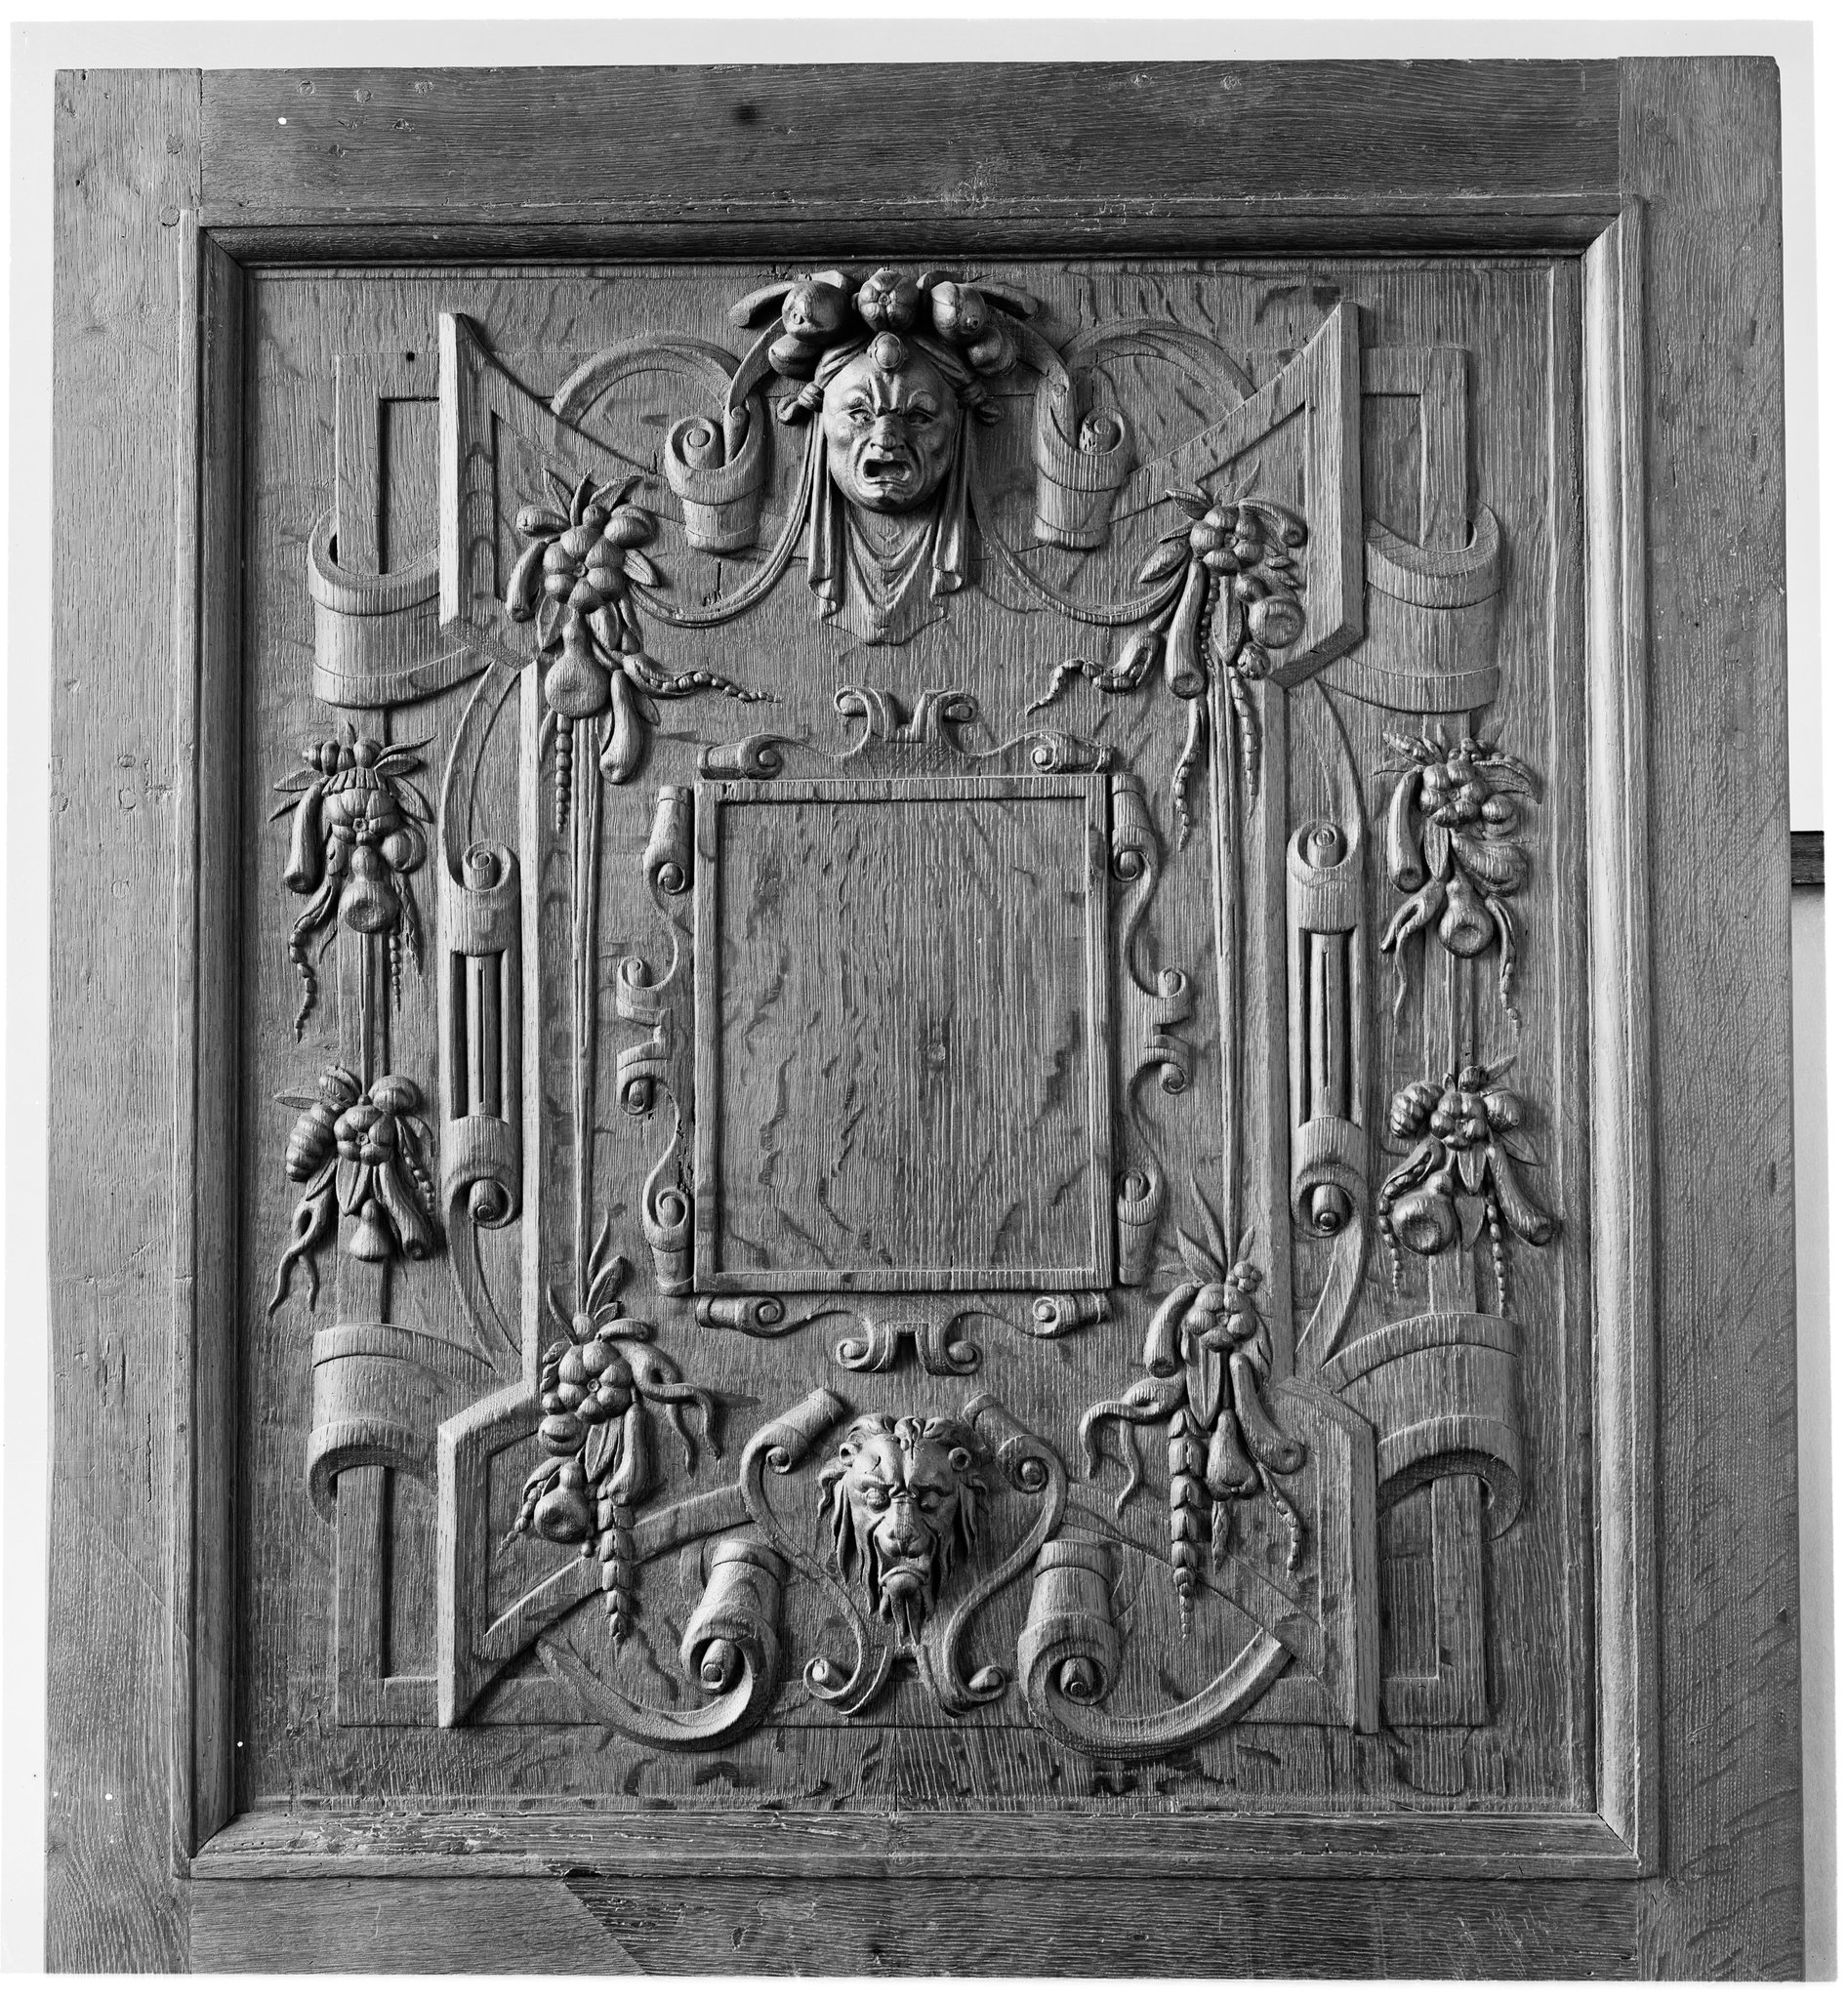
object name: door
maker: burgundy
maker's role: maker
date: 1551-1600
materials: wood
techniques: carving